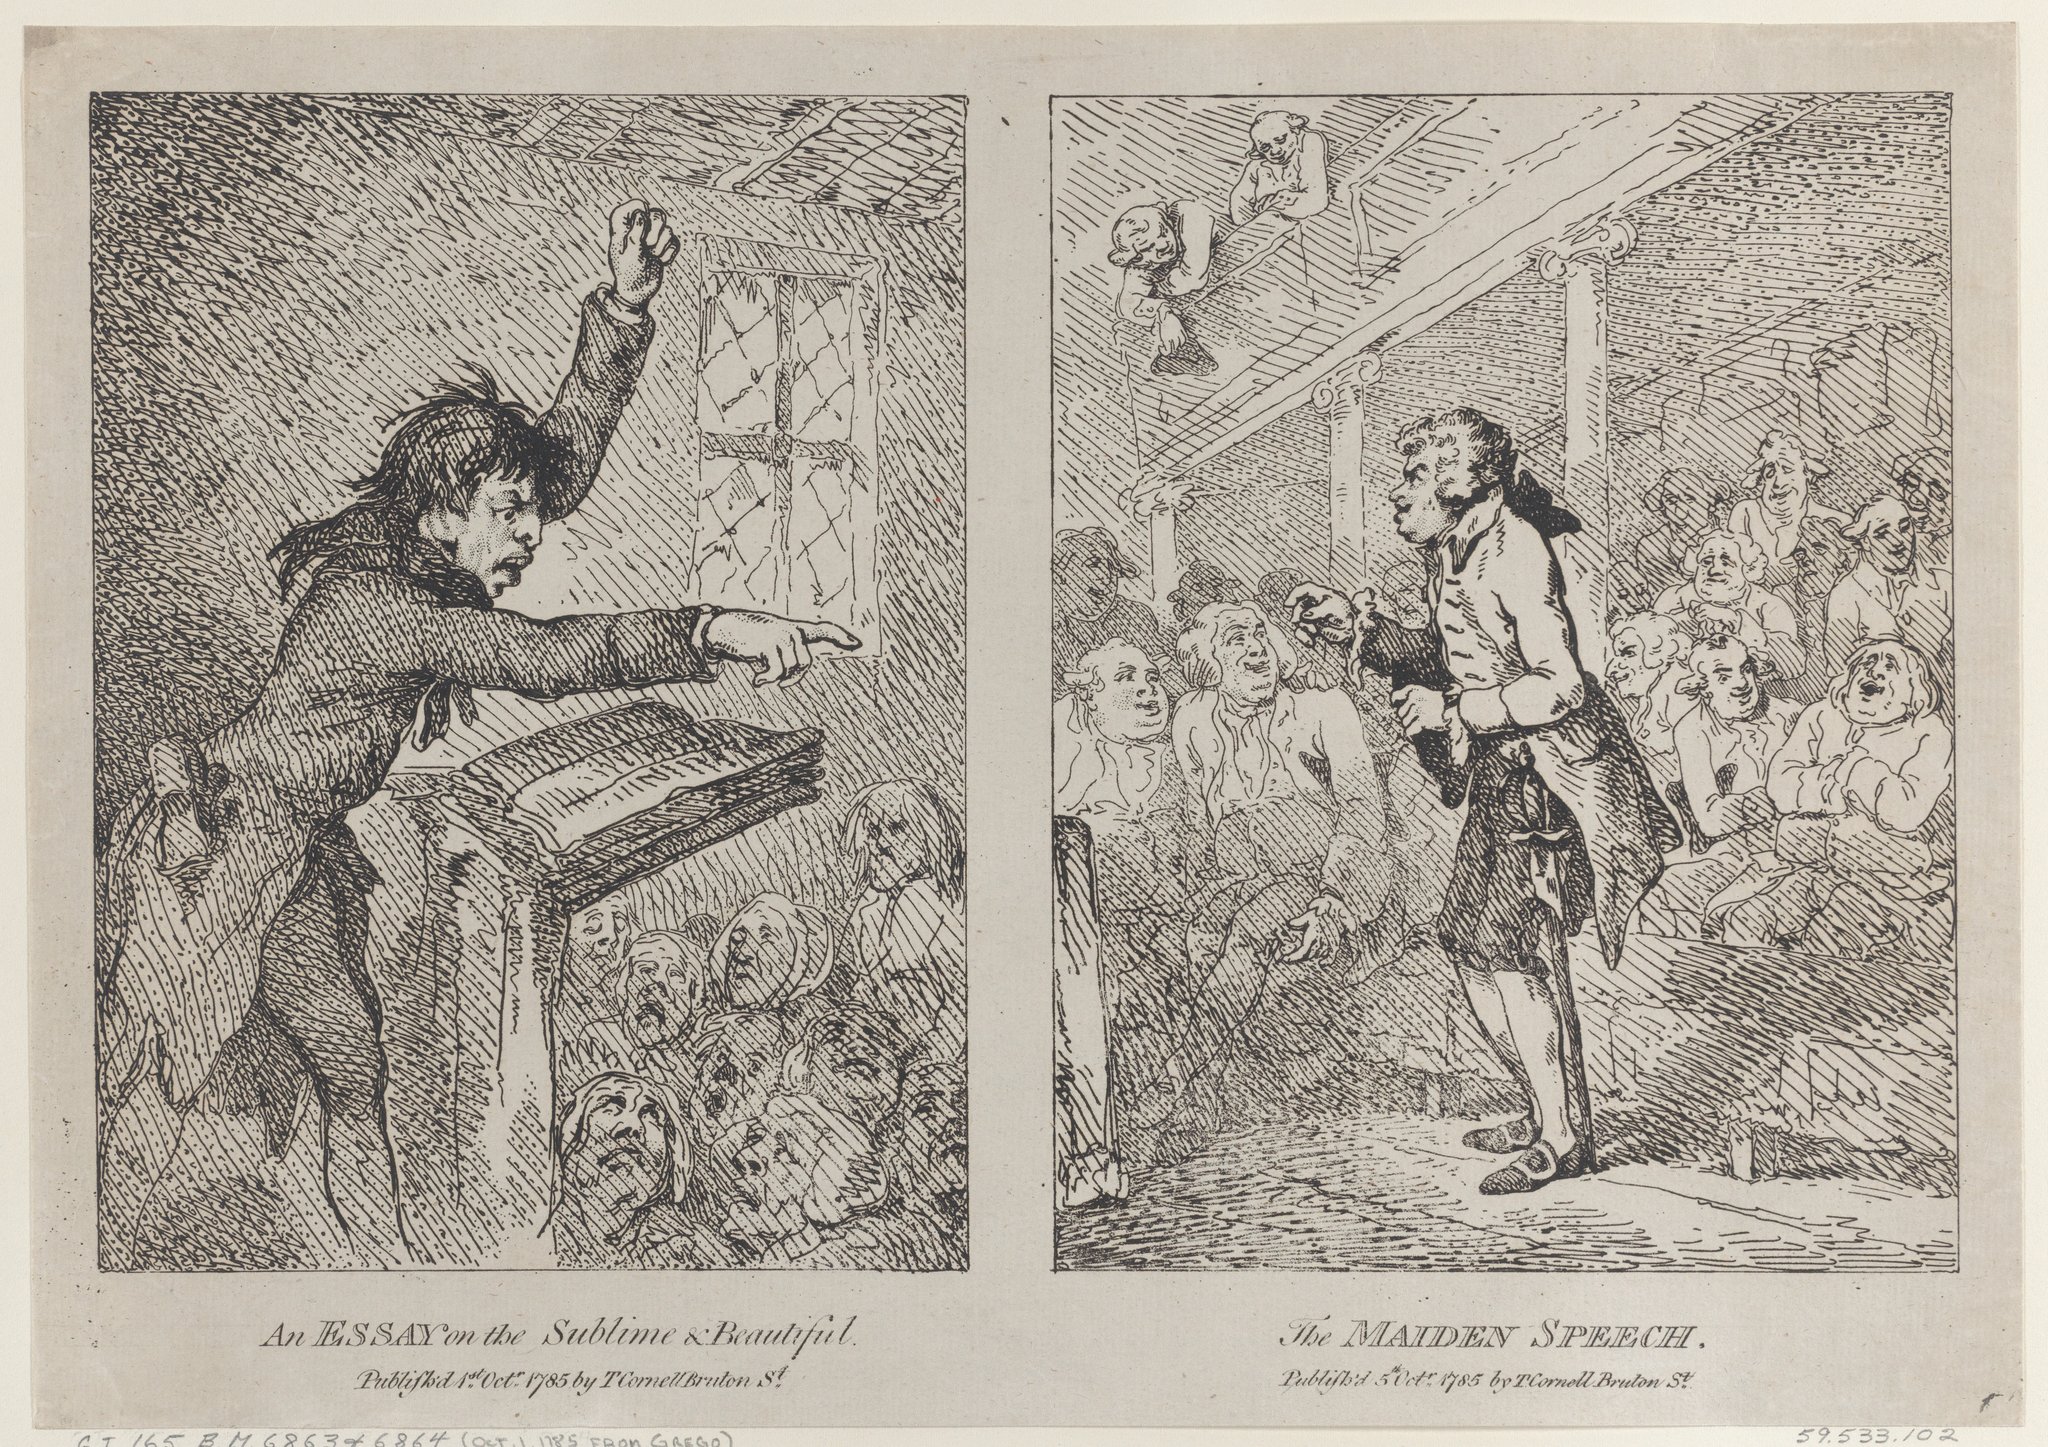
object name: print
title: An Essay on the Sublime & Beautiful; The Maiden Speech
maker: thomas rowlandson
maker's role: artist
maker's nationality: british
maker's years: 1757-1827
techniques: etching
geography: england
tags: satire,men